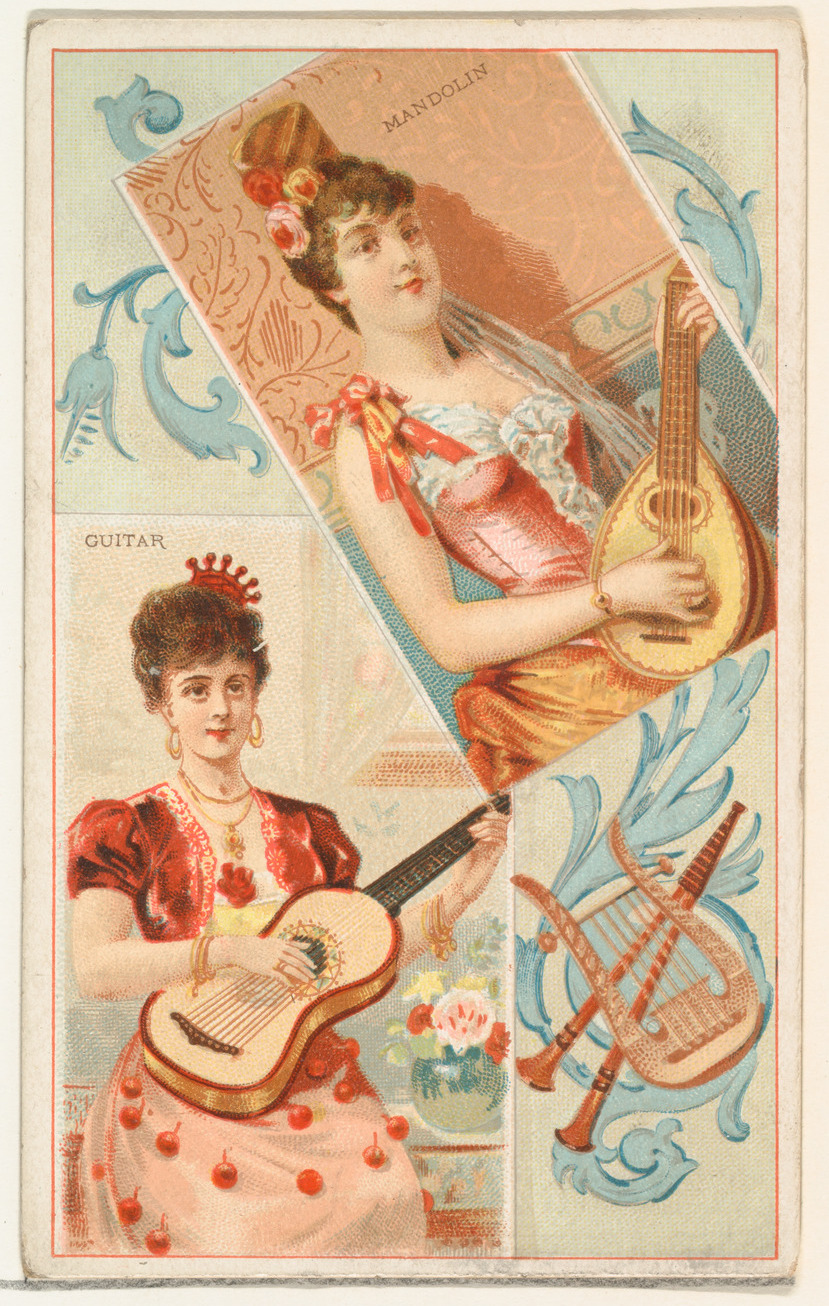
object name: print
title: Guitar and Mandolin, from the Musical Instruments series (N121) issued by Duke Sons & Co. to promote Honest Long Cut Tobacco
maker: w. duke, sons & co.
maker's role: publisher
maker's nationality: american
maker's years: 1870-1920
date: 1888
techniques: color lithograph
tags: women,guitars,mandolins